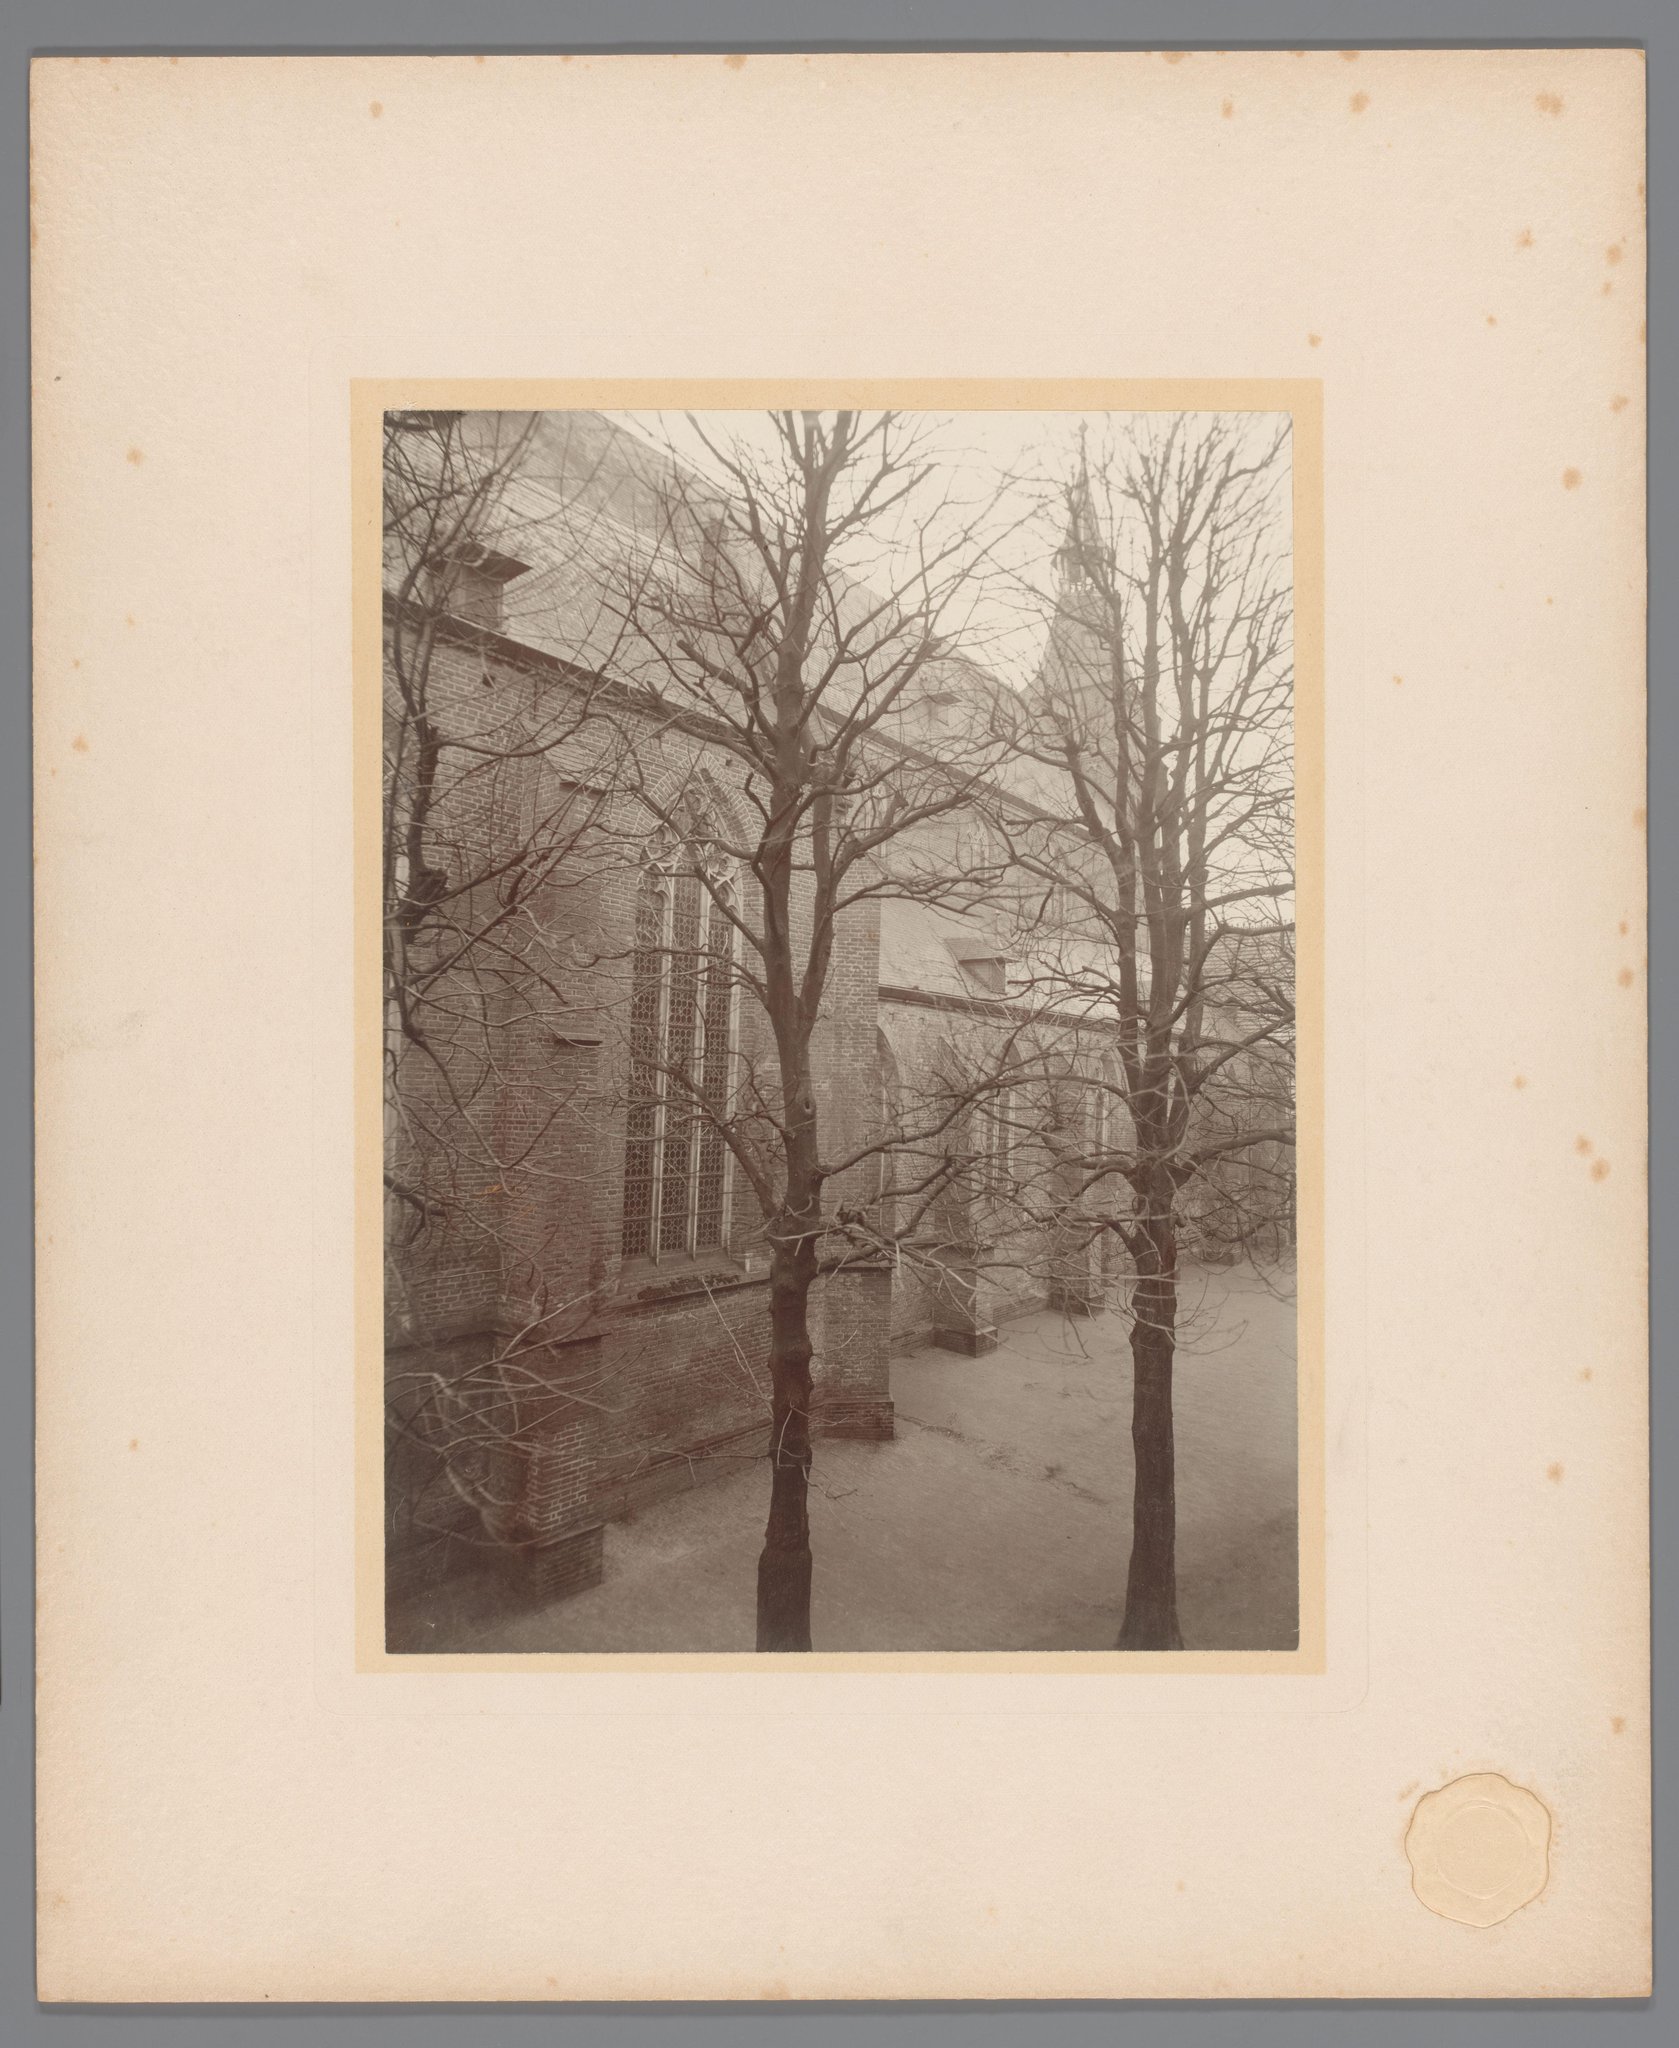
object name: photograph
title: Noordzijde van de Grote of Andreaskerk te Hattem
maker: henri bickhoff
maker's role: fotograaf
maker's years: 1866-1933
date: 1905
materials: cardboard, photographic support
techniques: collodion silver print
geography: hattem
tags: church (exterior)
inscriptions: annotation: ‘Hattem/ Gezicht op de N.H. Kerk/ van de Noordzijde’, annotation: ‘Erven J. Veth/ 1972’, inscription: ‘H. Bickhoff/ Amsterdam’